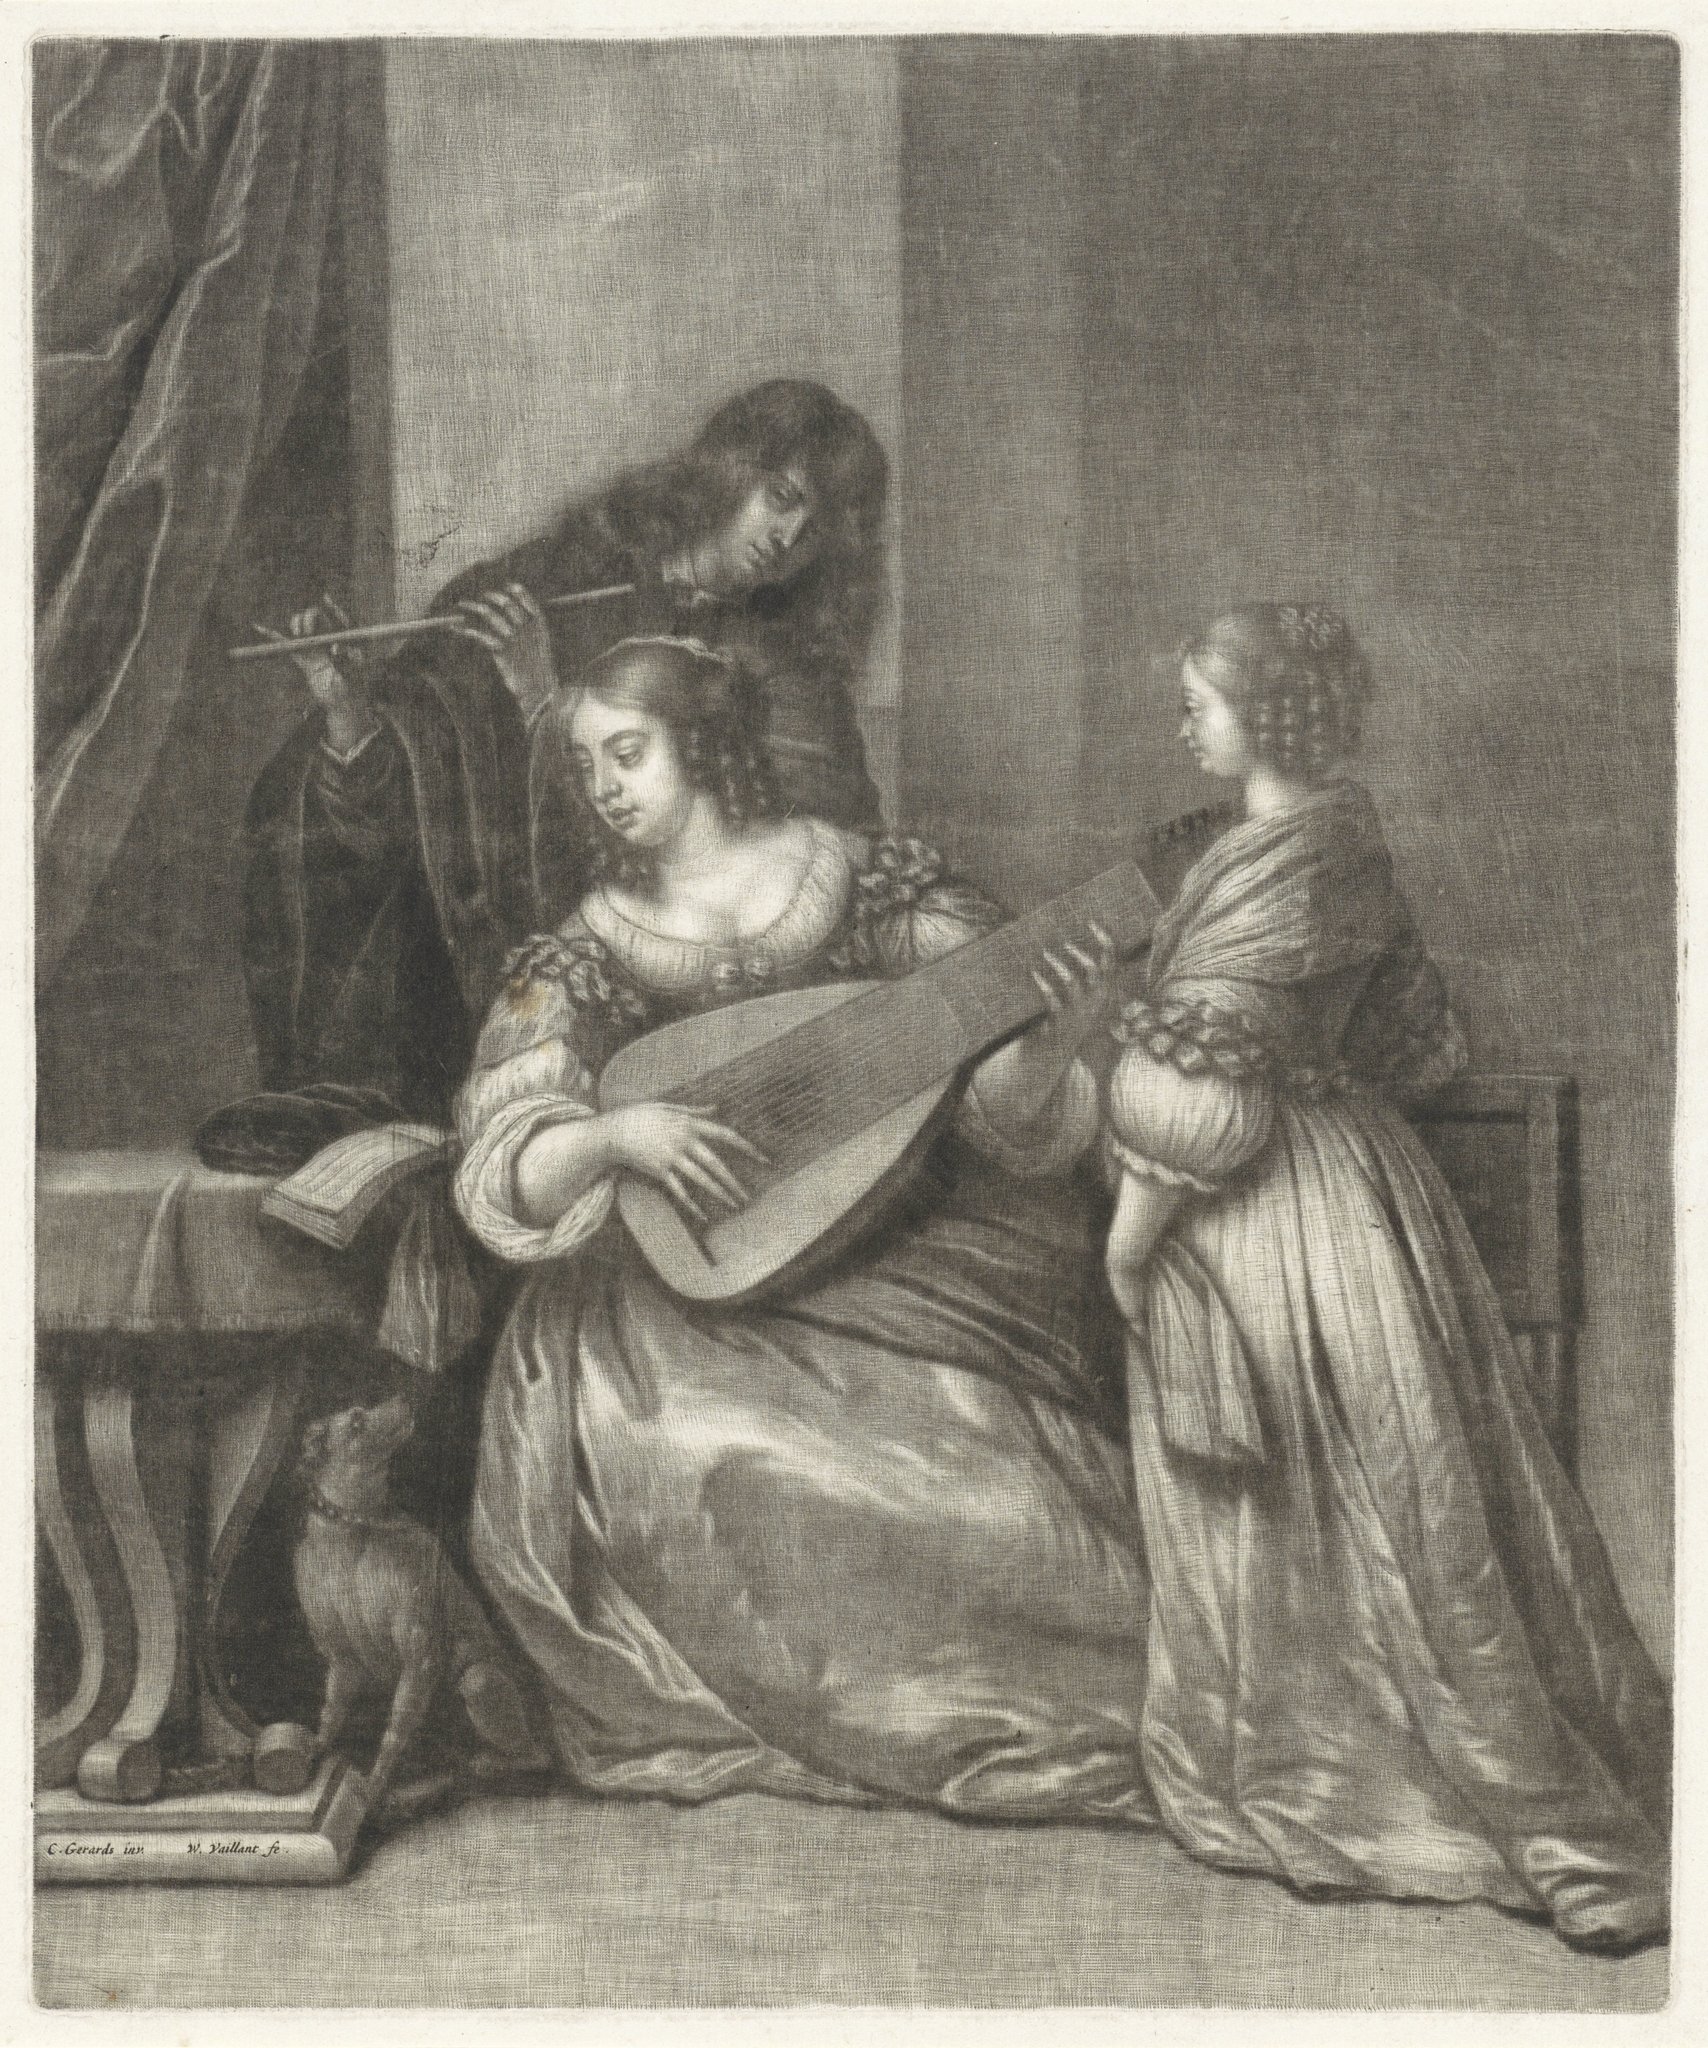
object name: print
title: Musicerend paar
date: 1658-1677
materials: paper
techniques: mezzotint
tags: small group of musicians, chamber orchestra, jazz band, transverse flute, dog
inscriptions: collector's mark: Lugt 2228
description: Een jonge vrouw bespeelt een luit en kijkt in het muziekboekje dat naast haar op de tafel ligt. Achter haar een jonge man die dwarsfluit speelt. Voor hen staat een meisje te luisteren. Naast de luitspeelster zit een hond.